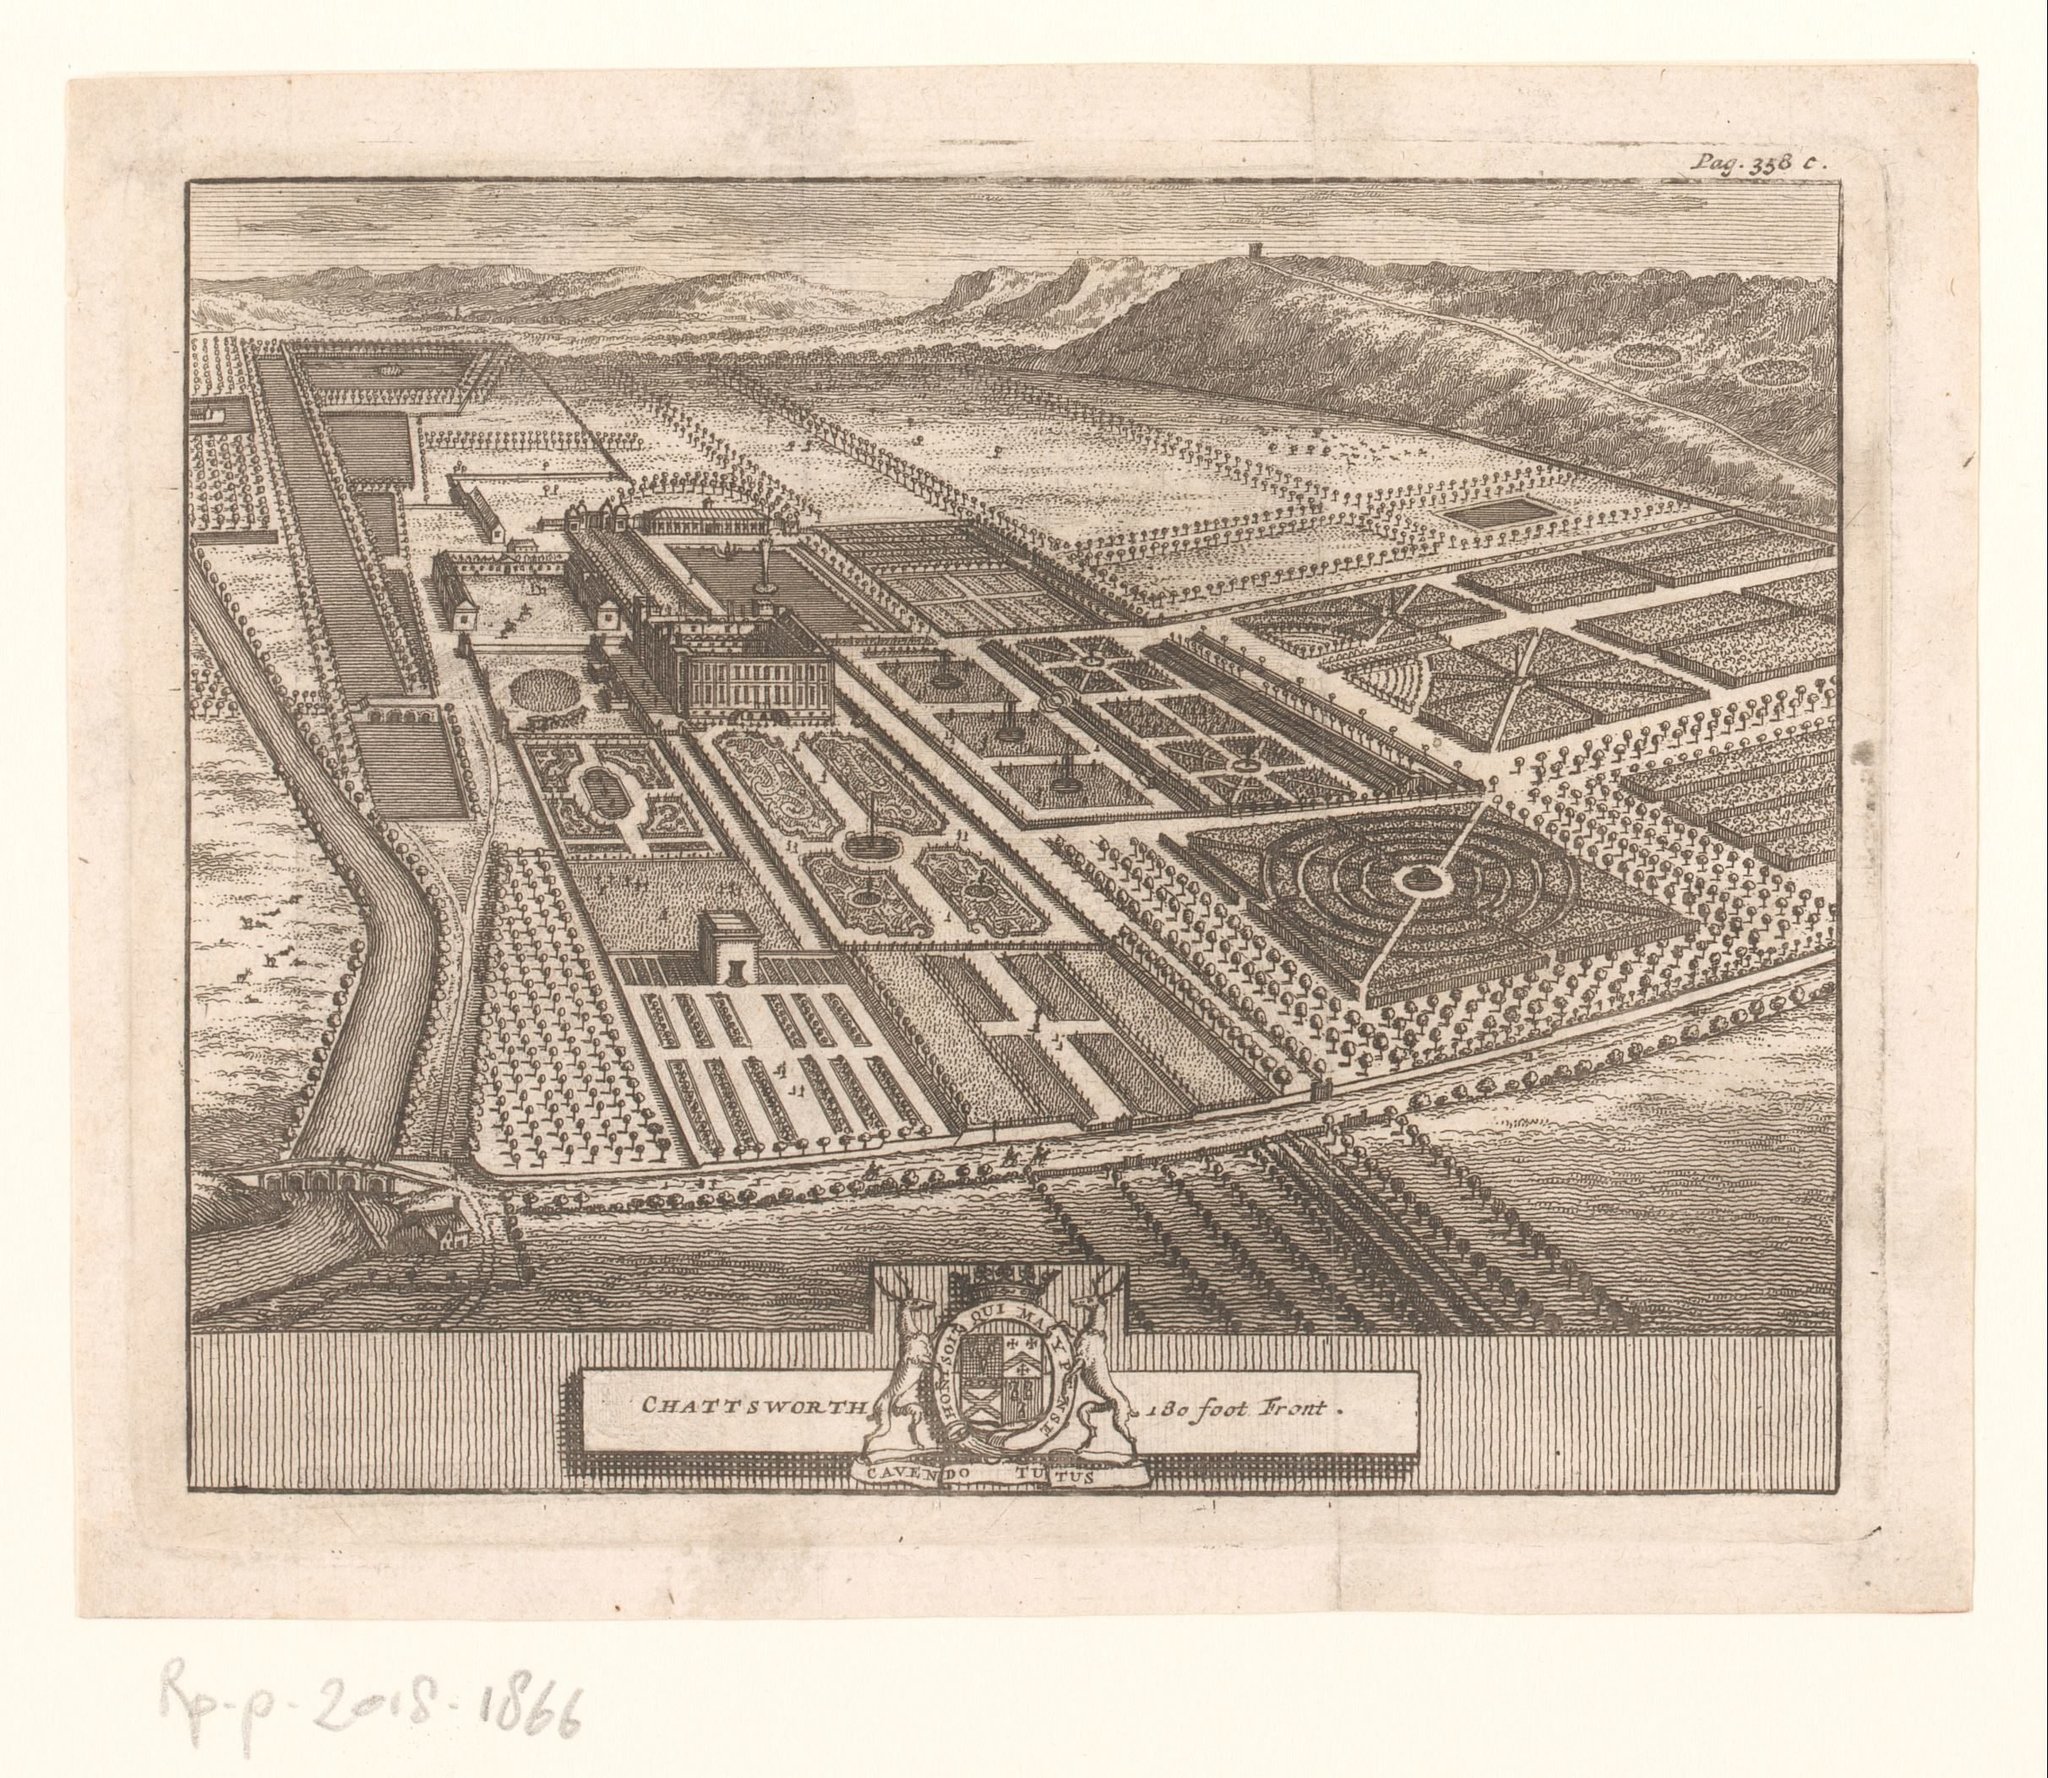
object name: print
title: Chattsworth 180 foot front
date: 1707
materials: paper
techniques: etching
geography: leiden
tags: castle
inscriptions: collector's mark: Lugt 2228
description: Prent gebruikt in: Beeverell, James. Les Delices de la Grande Bretagne et de l'Irlande (...). Leiden: Pieter van der Aa, 1707.